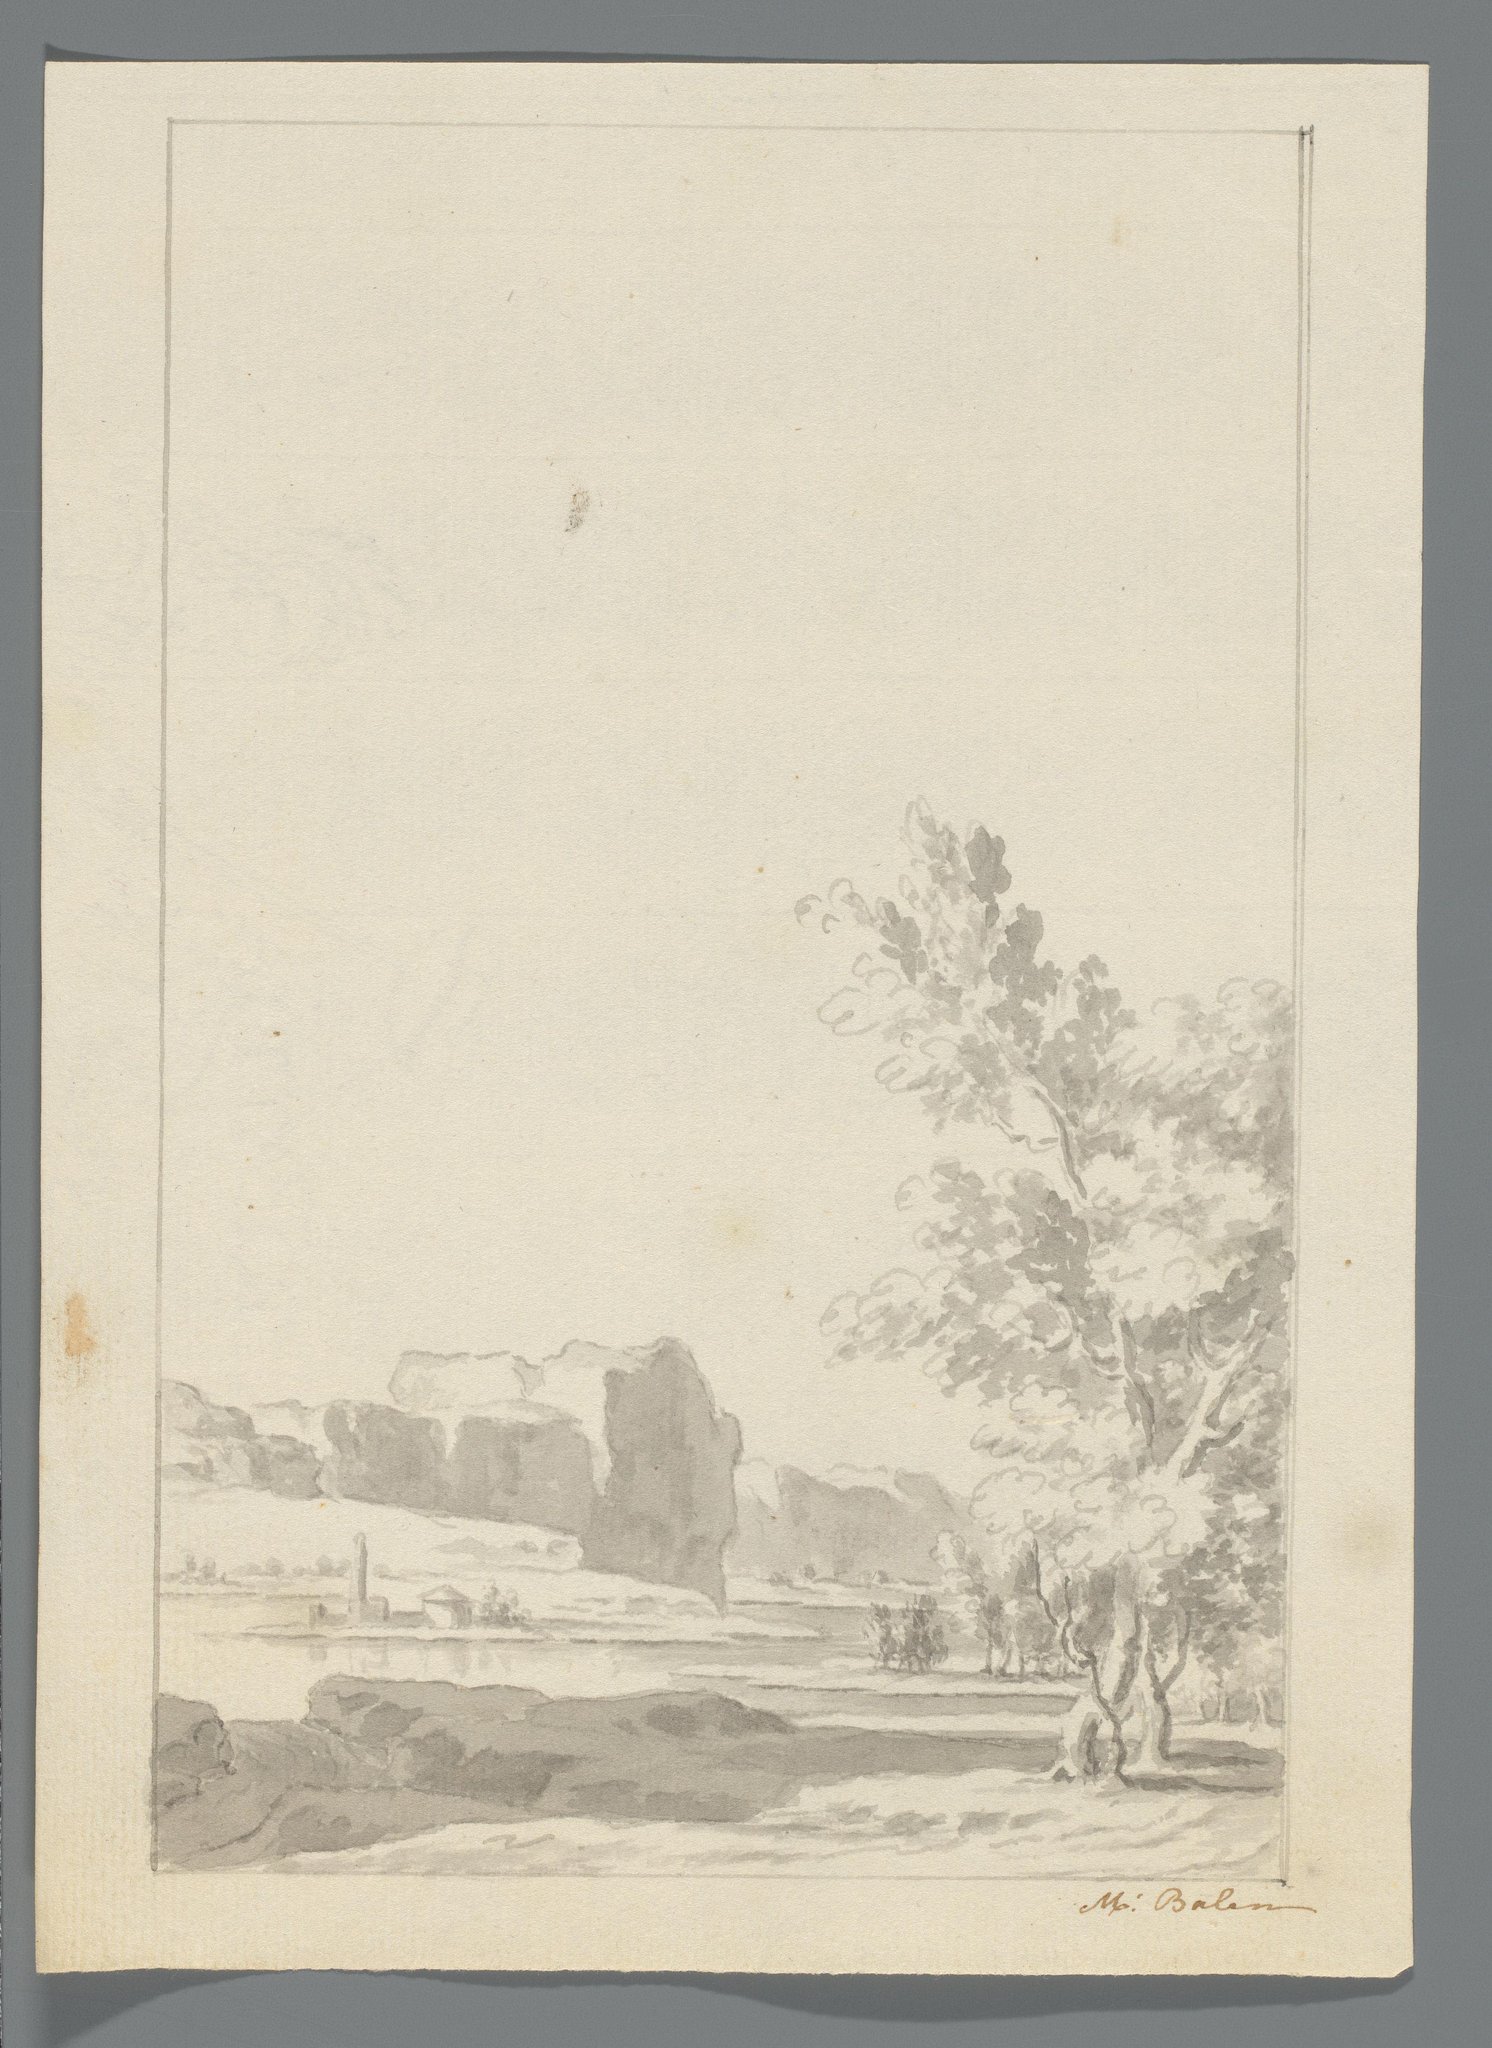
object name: drawing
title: Rivierlandschap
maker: matthijs balen (1684-1766)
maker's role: draughtsman, painter, print maker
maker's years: 1684-1766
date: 1694-1766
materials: paper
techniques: brush, pen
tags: landscapes with waters, waterscapes, seascapes (in the temperate zone)